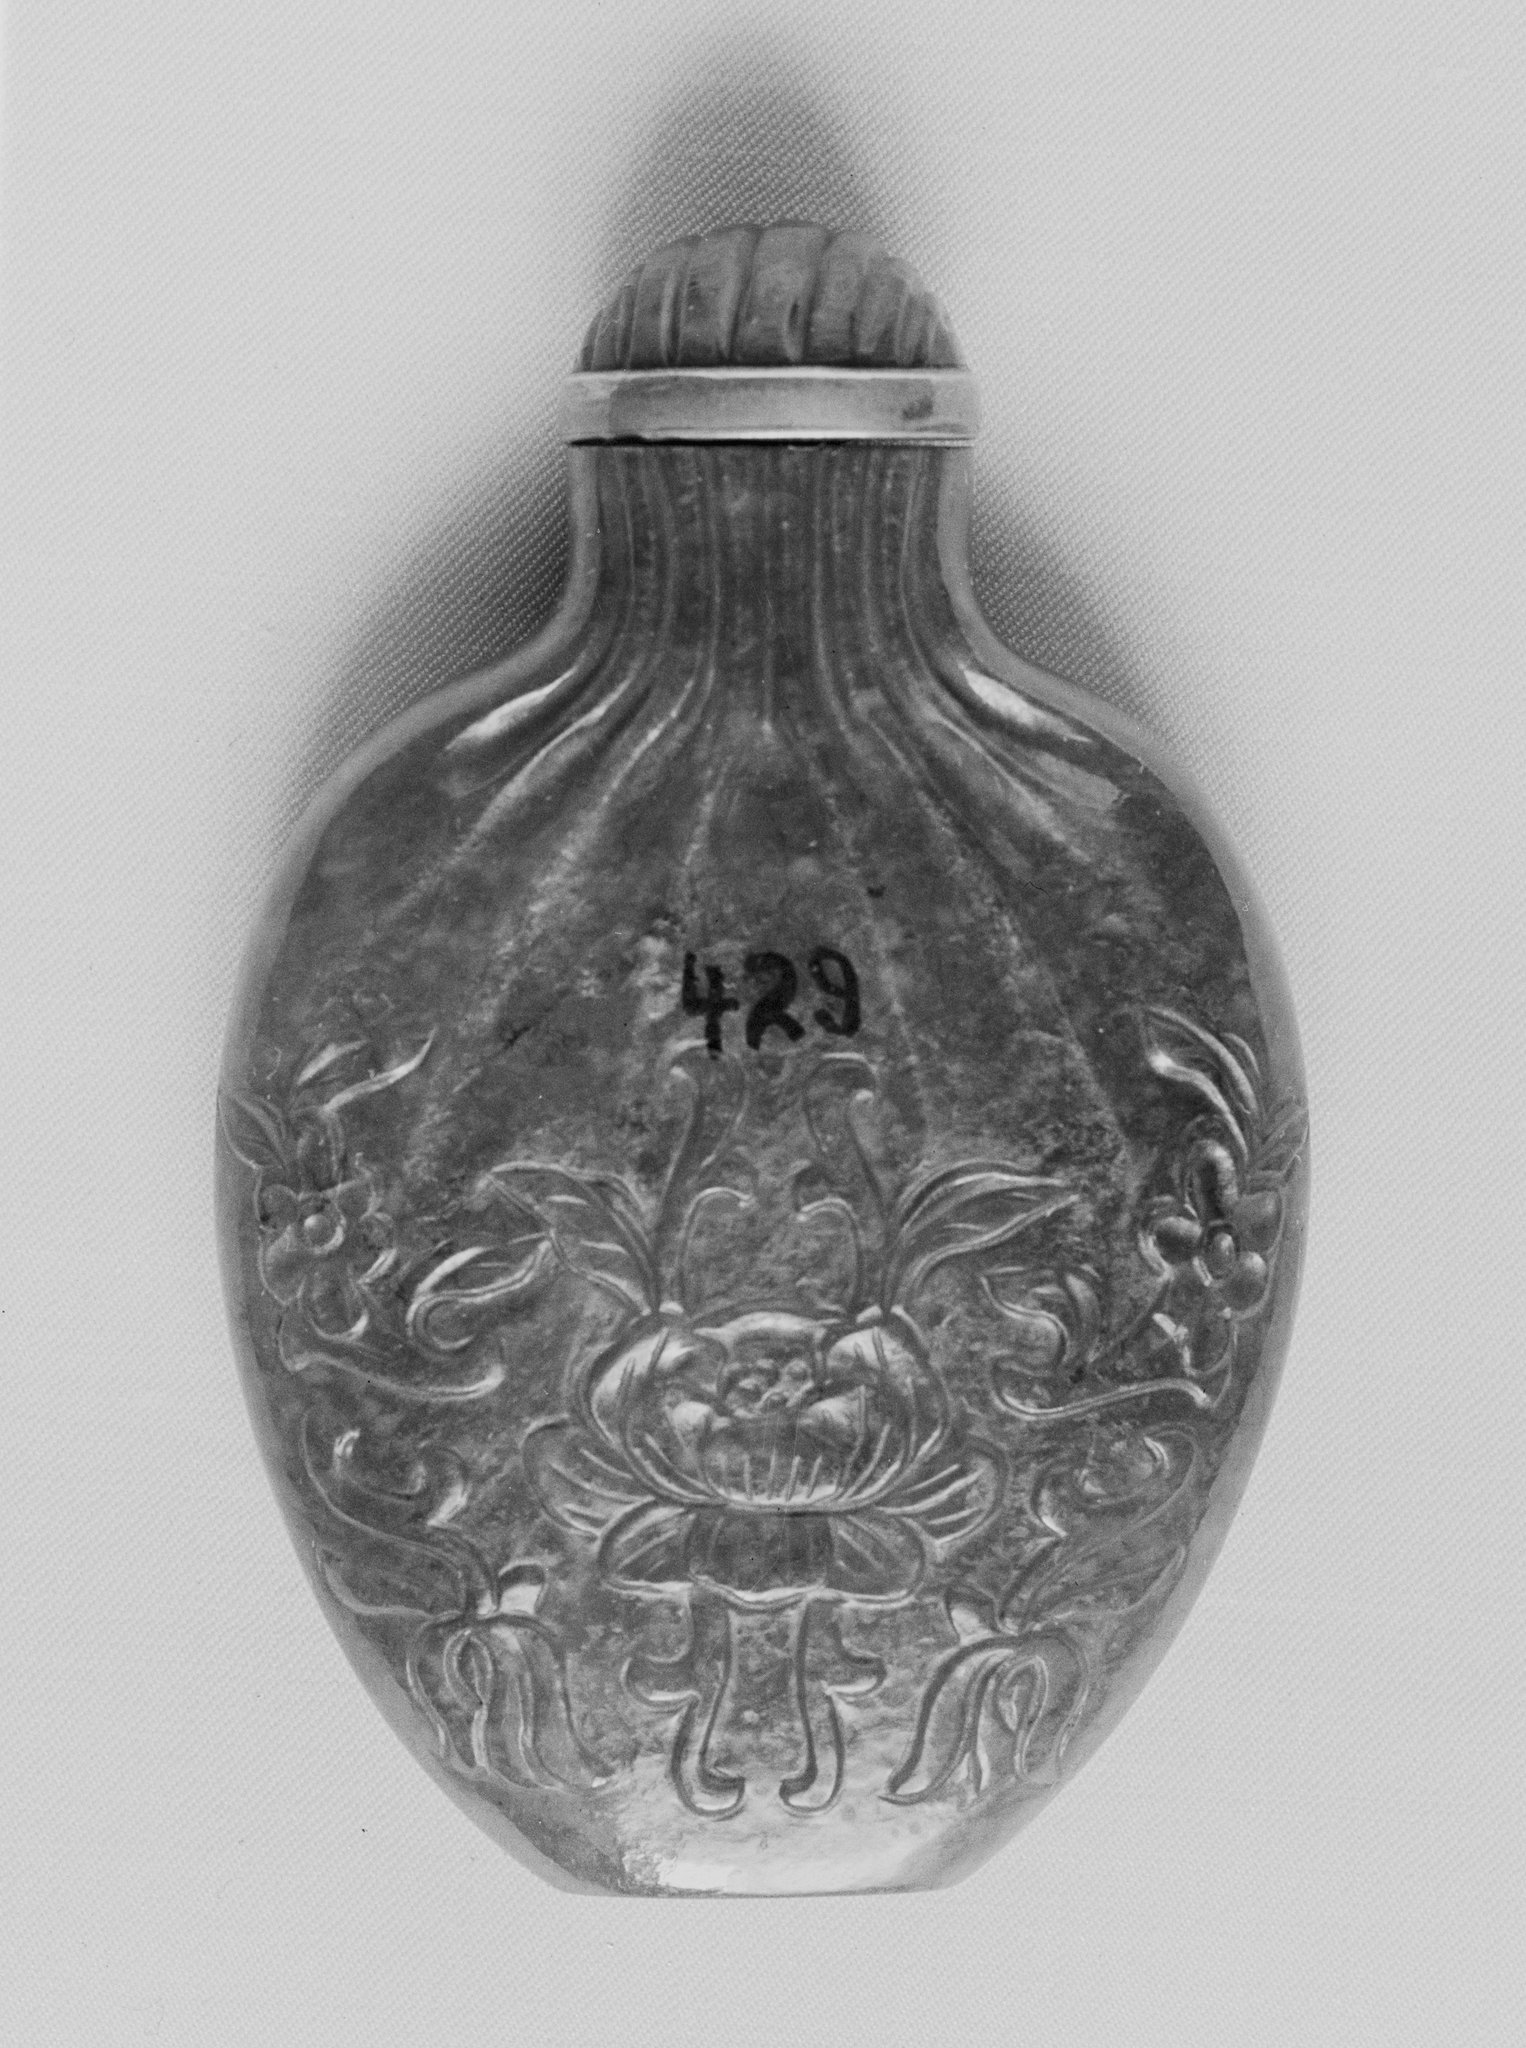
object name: snuff bottle with stopper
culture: chinese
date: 1662-1722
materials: gemstone, jade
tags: flowers